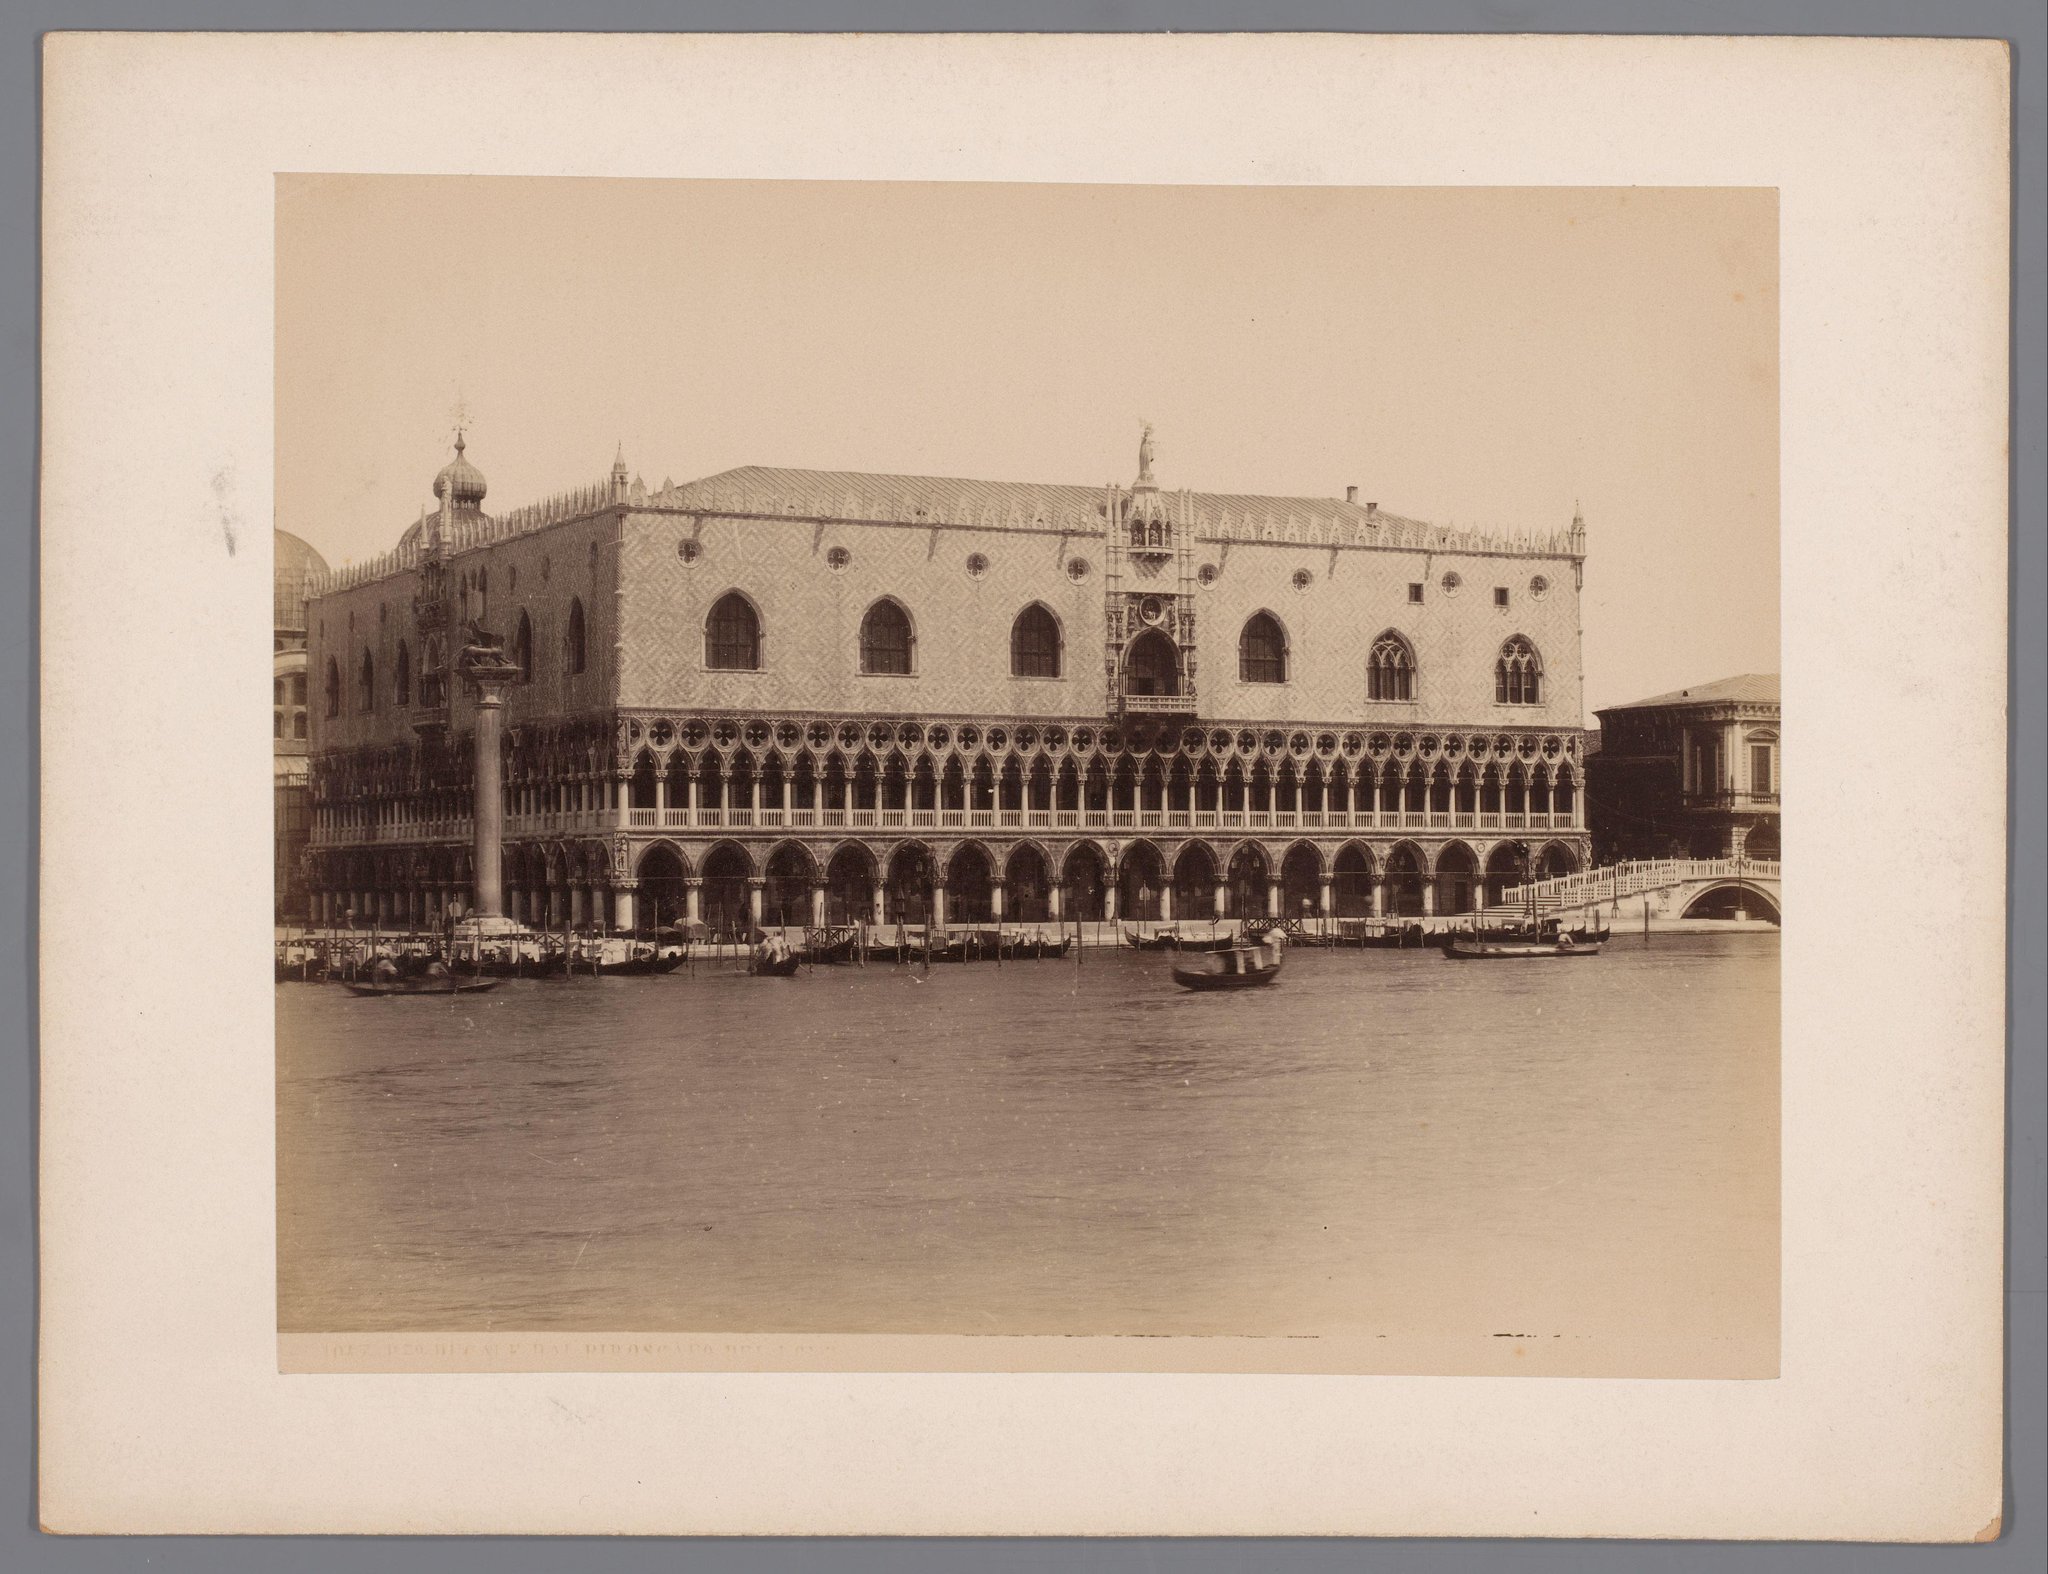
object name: photograph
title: Gezicht op het Dogepaleis vanaf het water te Venetië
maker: paolo salviati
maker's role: fotograaf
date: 1860-1870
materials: cardboard, paper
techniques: albumen print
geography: venice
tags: palace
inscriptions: inscription: ‘Salviati (t)’, title: ‘[...]’, number: ‘1047’